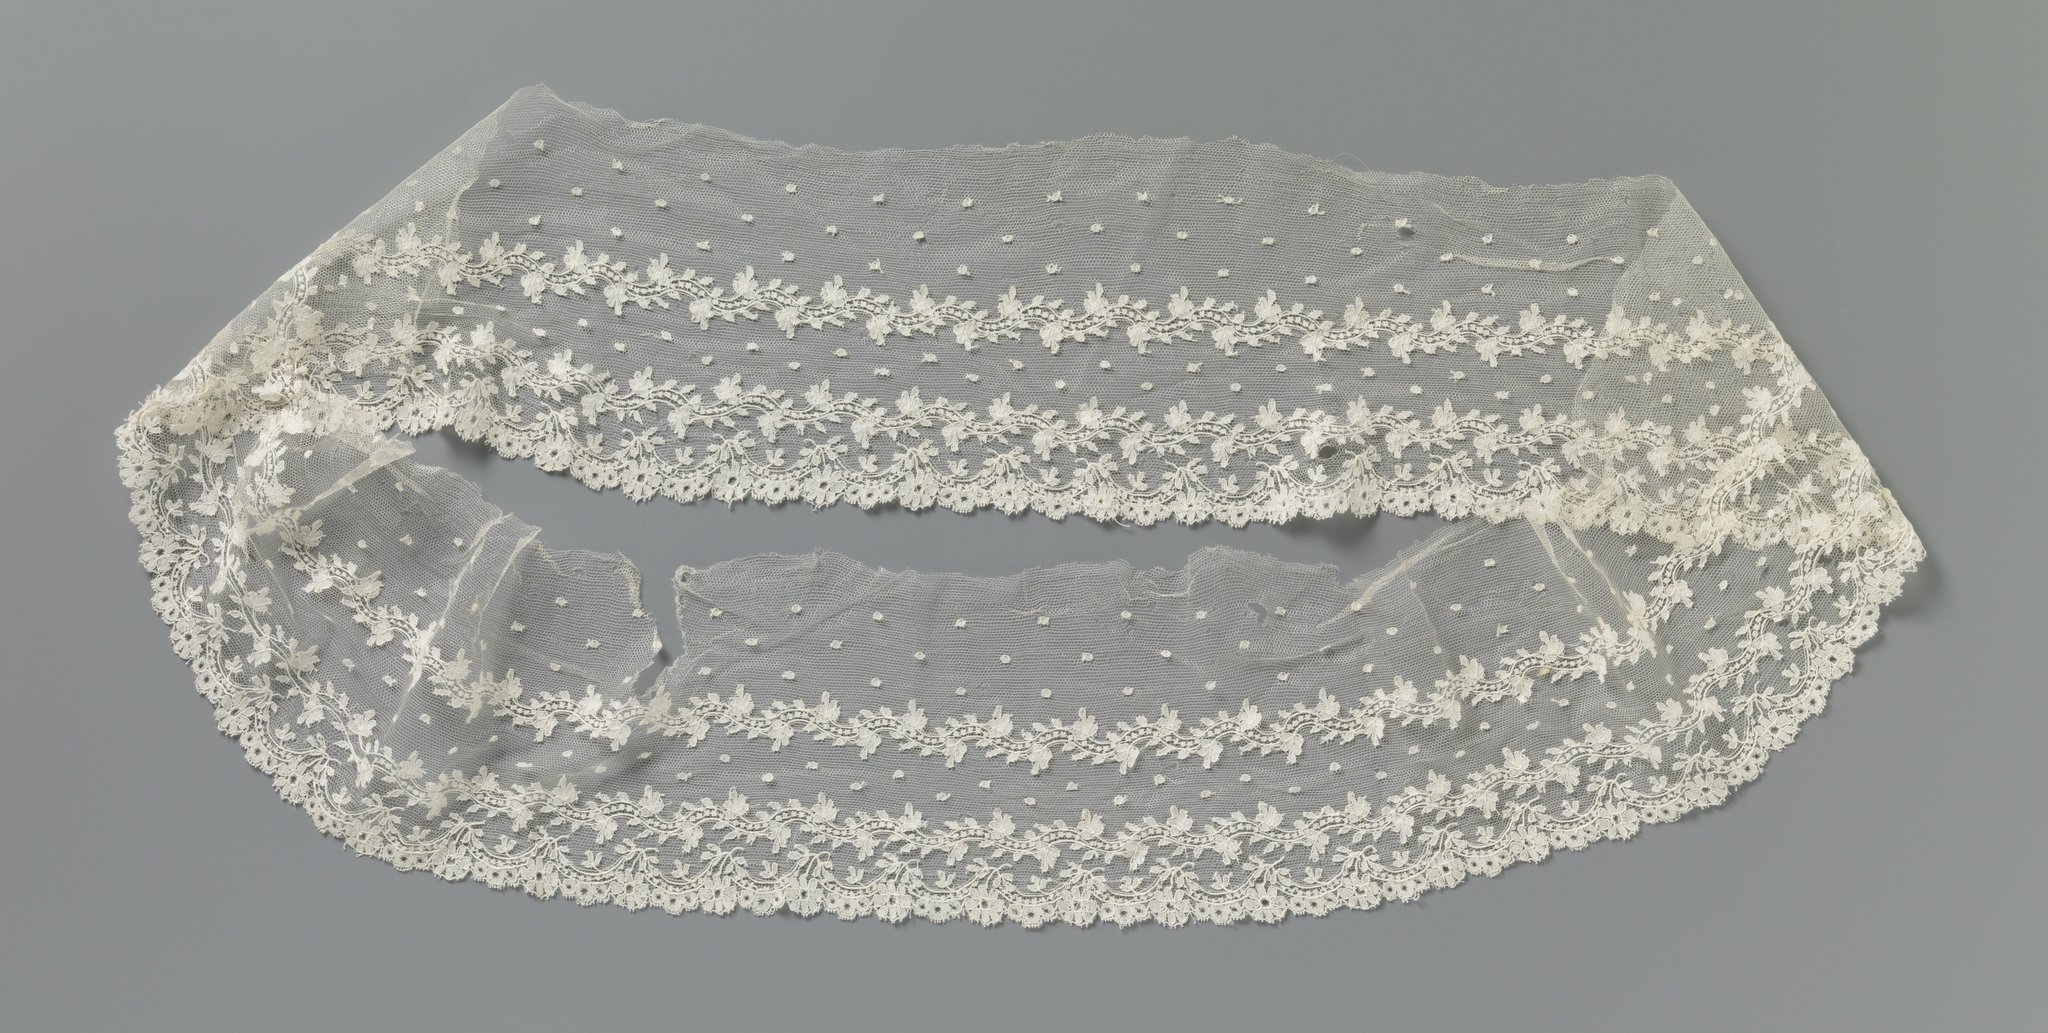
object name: strip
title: Strook machinale kant met golvende bladerranken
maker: Anonymous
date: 1900-1949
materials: silk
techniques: lace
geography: calais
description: Strook naturelkleurige machinale kant. Strooimotief met stippen op een fijne zeshoekige traliegrond. Boven het midden loopt een golvende band die bestaat uit twee ijle ranken met kleine en grotere blaadjes waartussen een stippellijn. Deze band herhaald zich onder het midden, waar het zich voegt in het patroon van de geschulpte onderzijde. Dit patroon bestaat uit hangende rozetbloempjes die met gestippelde boogjes met daaronder drie cirkels aan elkaar verbonden zijn. De bovenzijde is afgeknipt en niet afgewerkt. De korte zijden van de strook zijn aan elkaar genaaid.